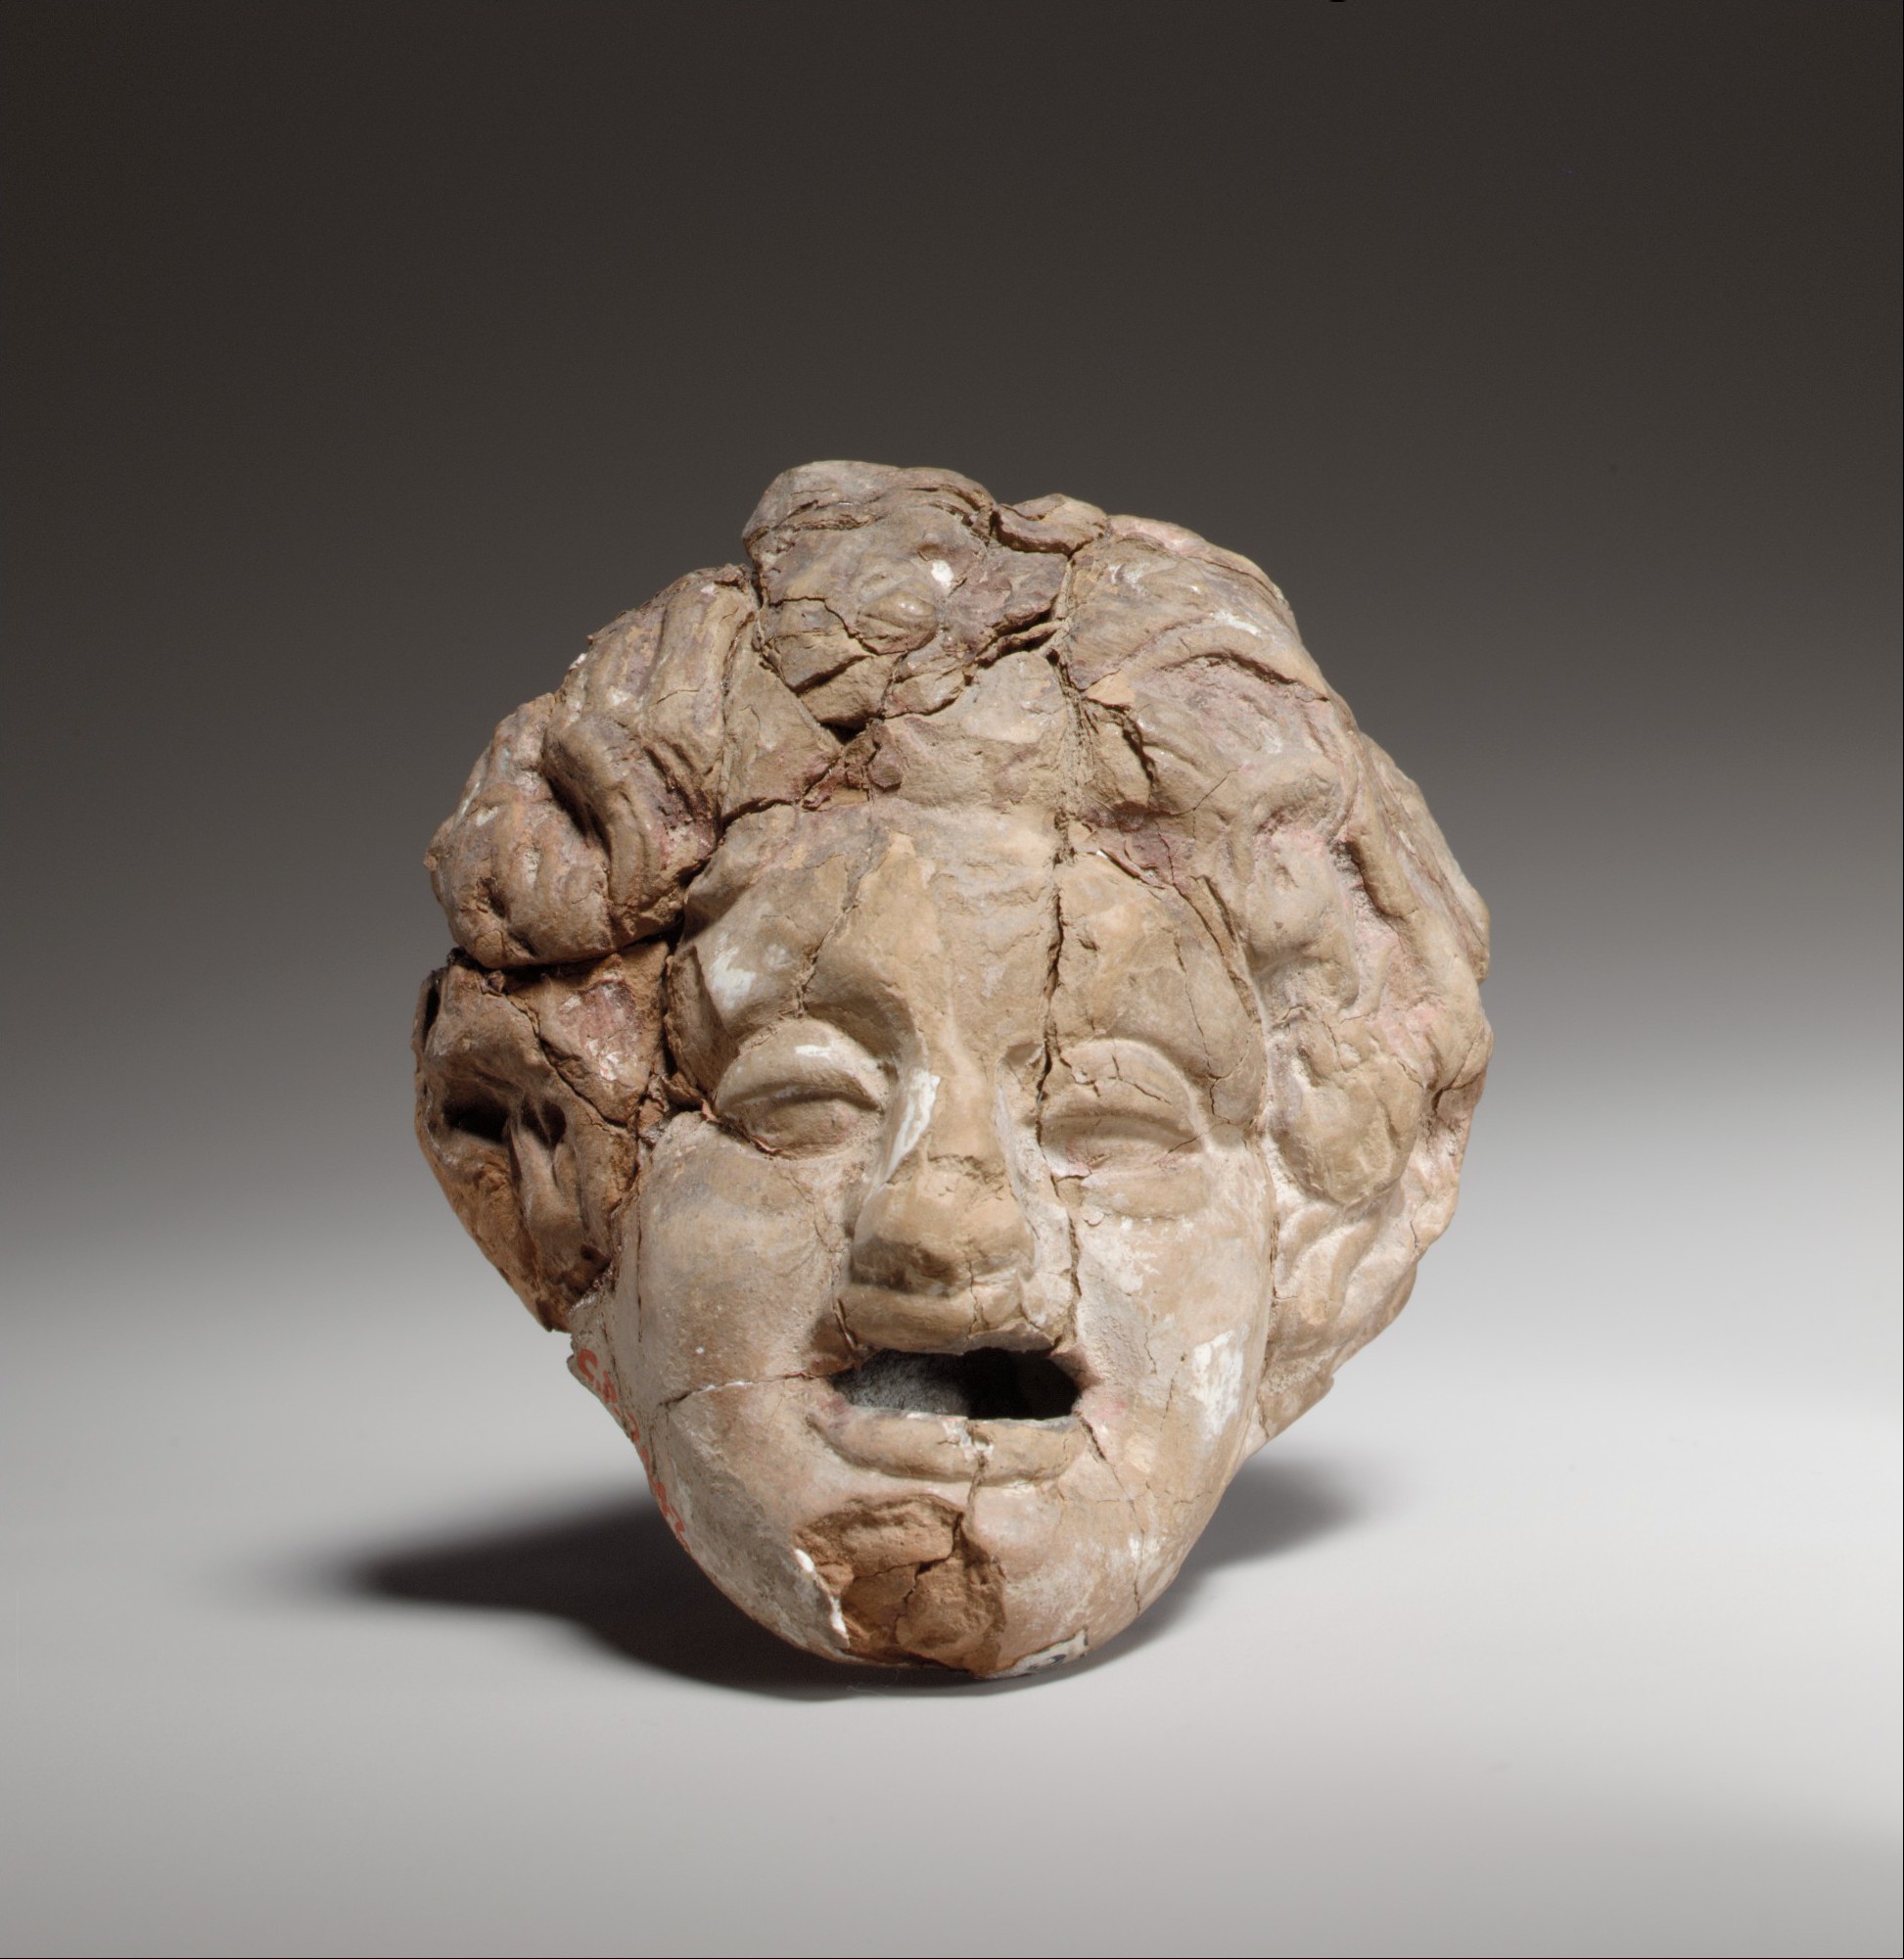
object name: mask, comic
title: Comic mask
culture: greek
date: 334-201 BCE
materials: terracotta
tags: masks